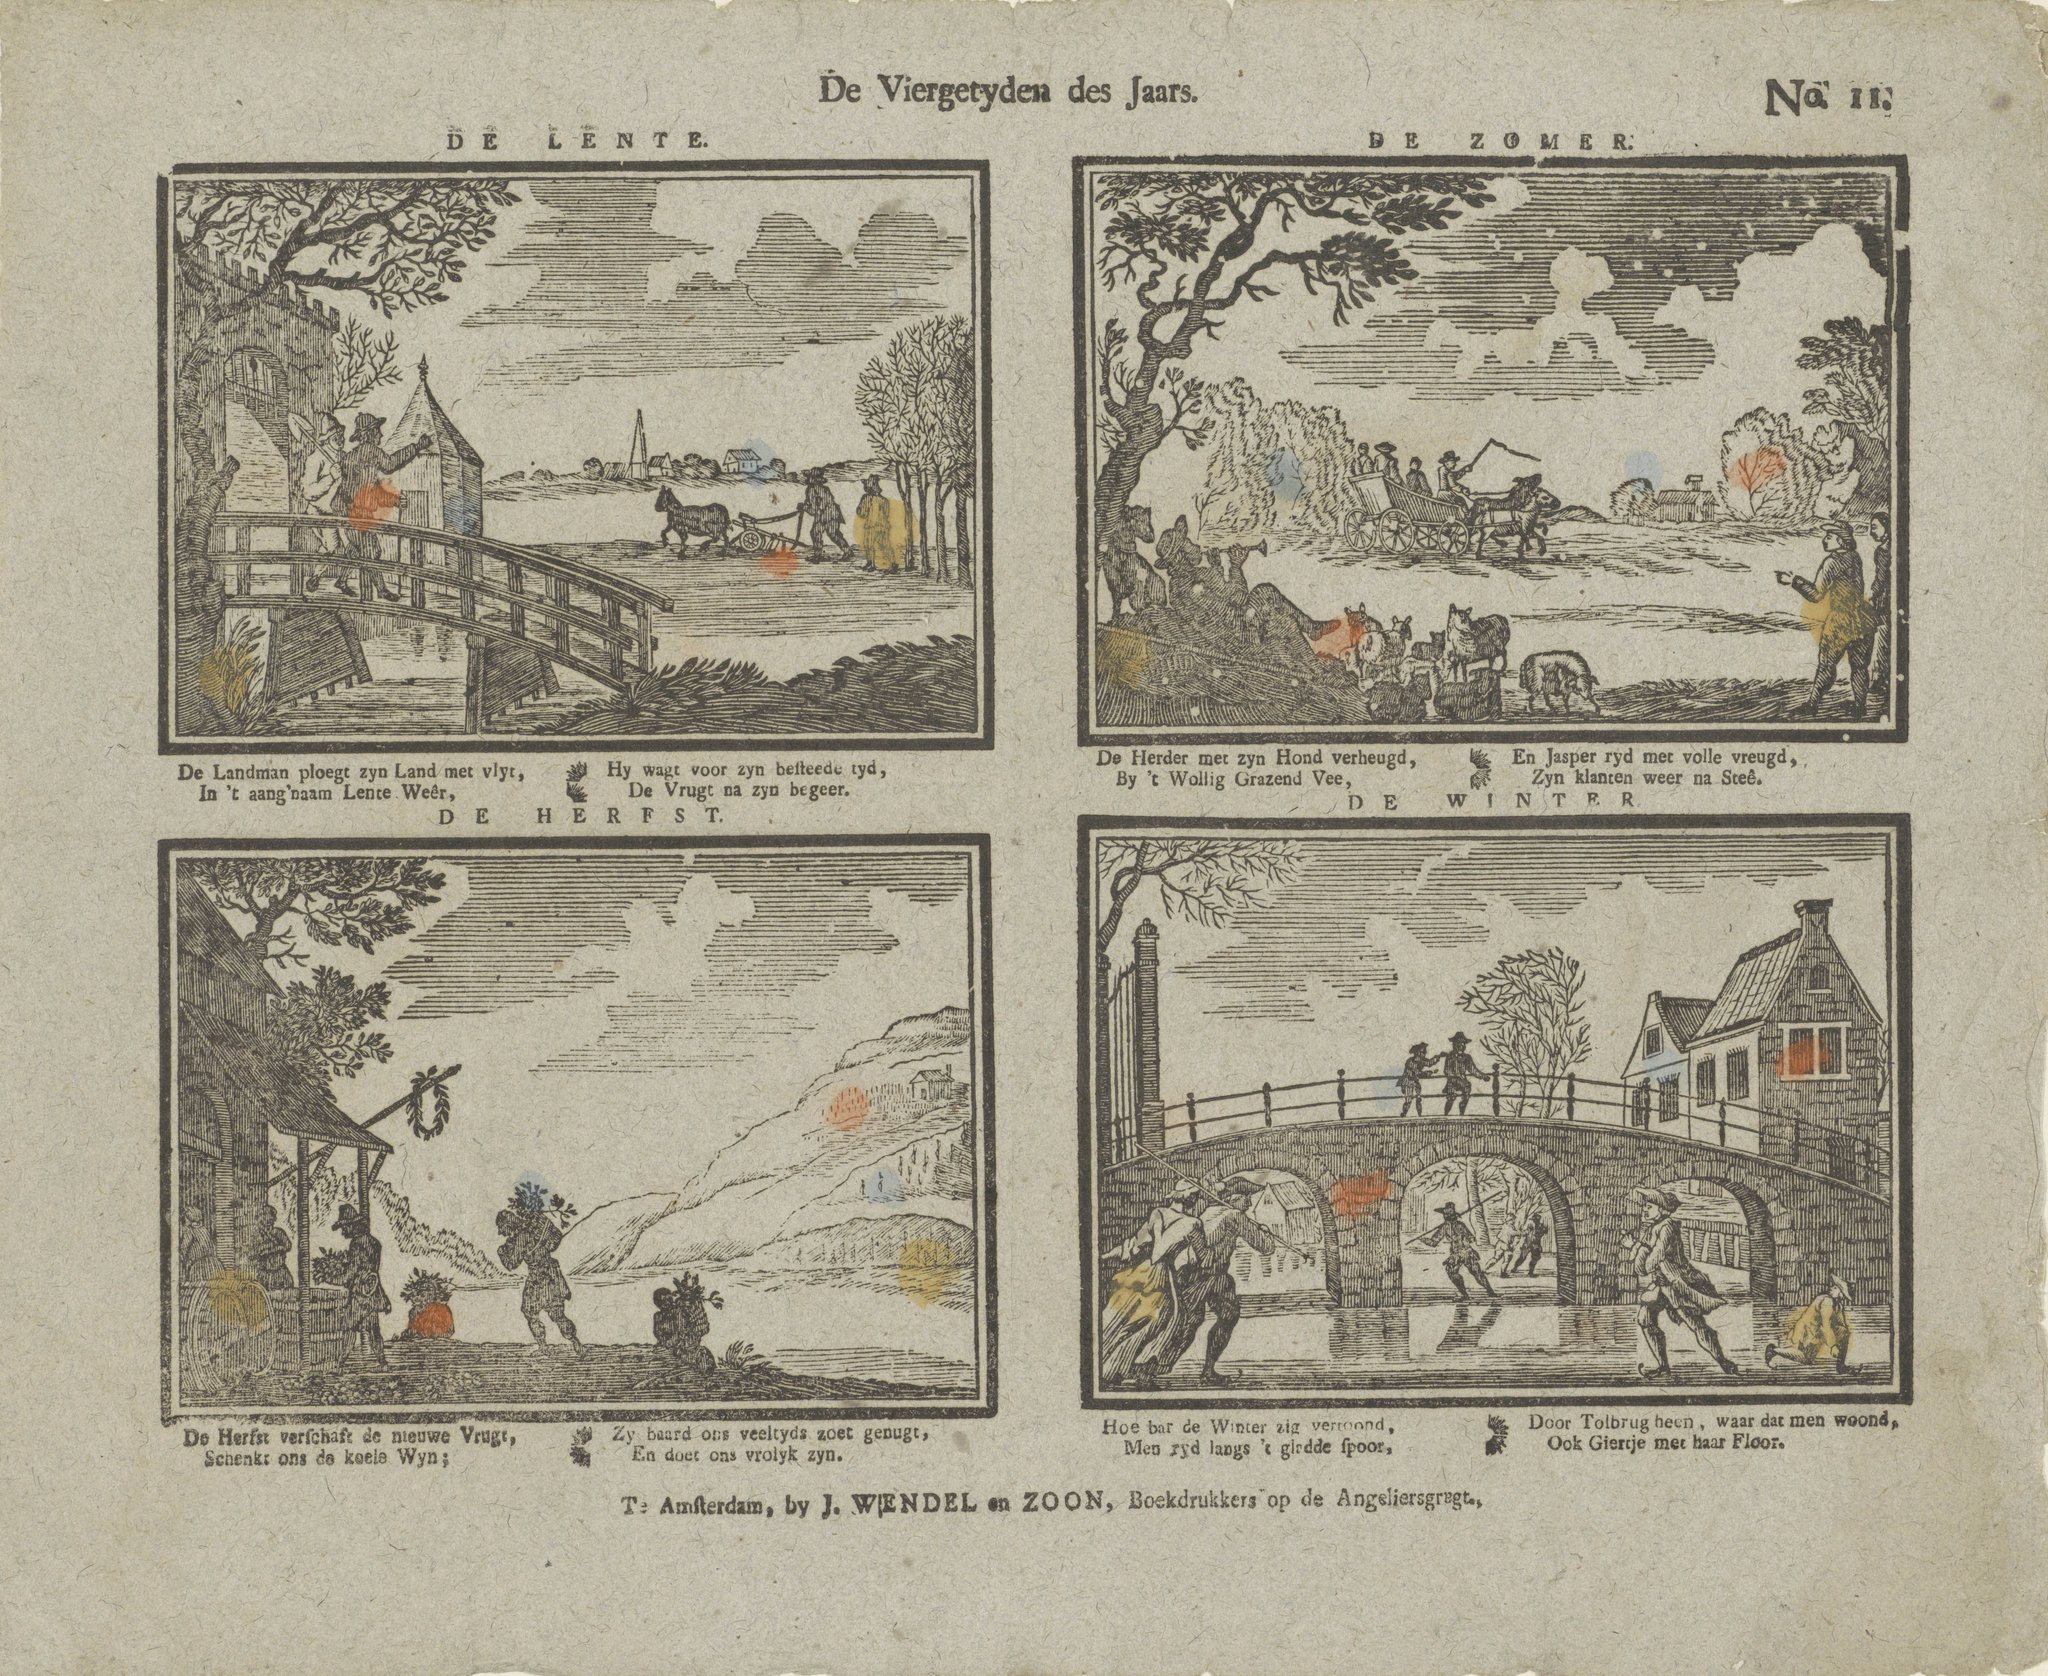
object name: popular print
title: De viergetyden des jaars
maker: Anonymous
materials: paper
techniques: colour, letterpress printing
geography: amsterdam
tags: the four seasons of the year ~ human activities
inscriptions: collector's mark: Lugt 2760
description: Blad met 4 voorstellingen van de vier jaargetijden. Boven elke afbeelding de naam van het seizoen, onder elke afbeelding een vierregelig vers. Genummerd rechtsboven: No. 11.